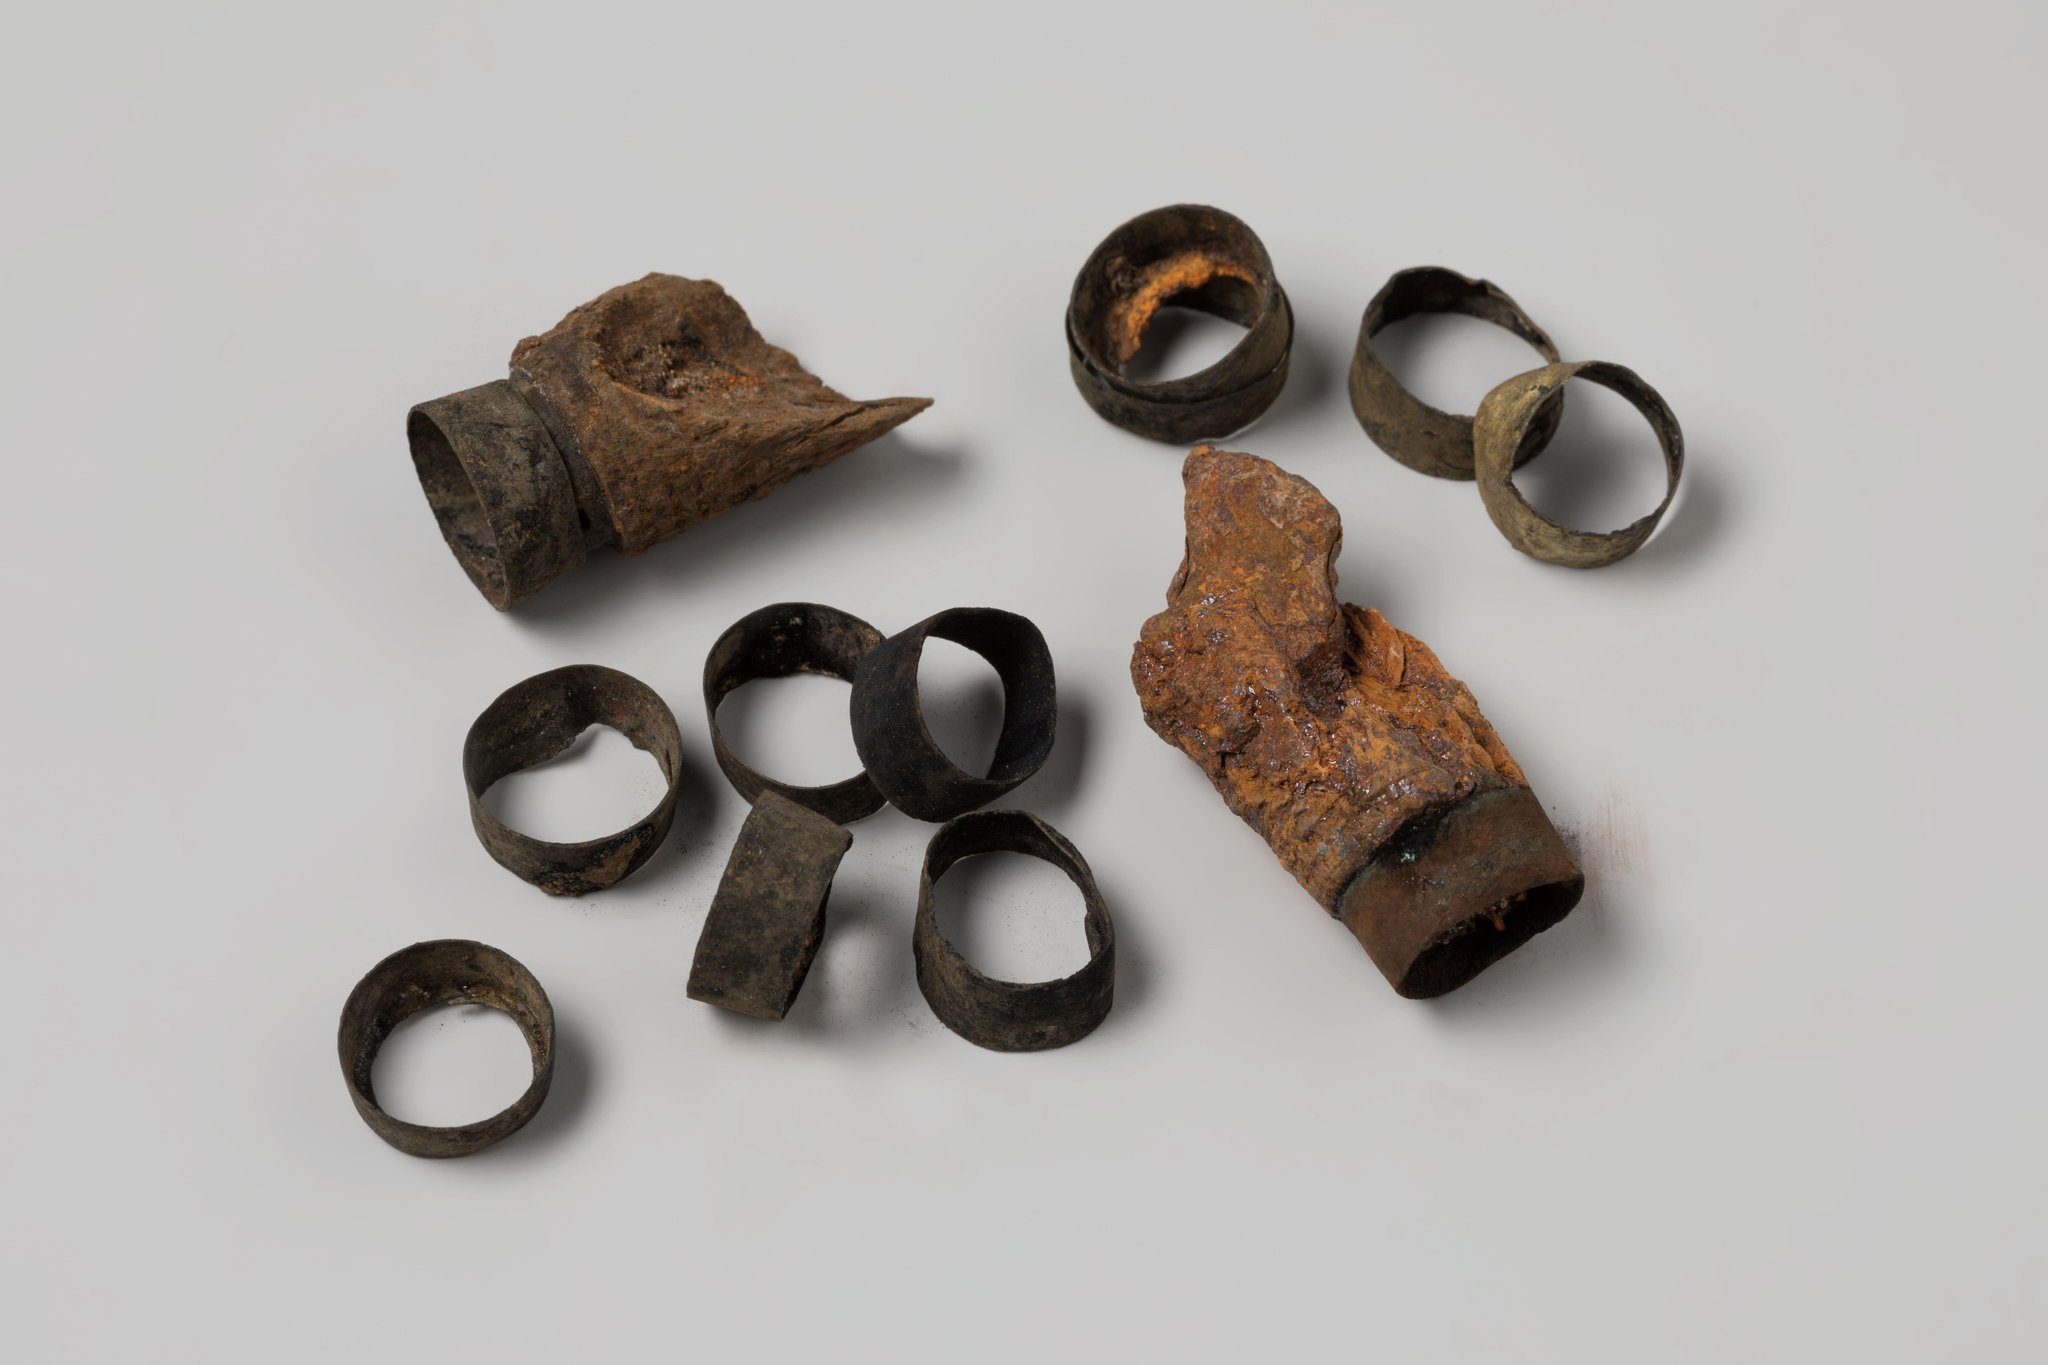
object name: ferrule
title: Messenheftring uit het wrak van de Oost-Indiëvaarder Hollandia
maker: Anonymous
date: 1700-1743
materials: copper, wood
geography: netherlands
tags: verenigde oostindische compagnie, hollandia (schip), annet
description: Knife-handle, ferrule; id. NG 1980-27H426.